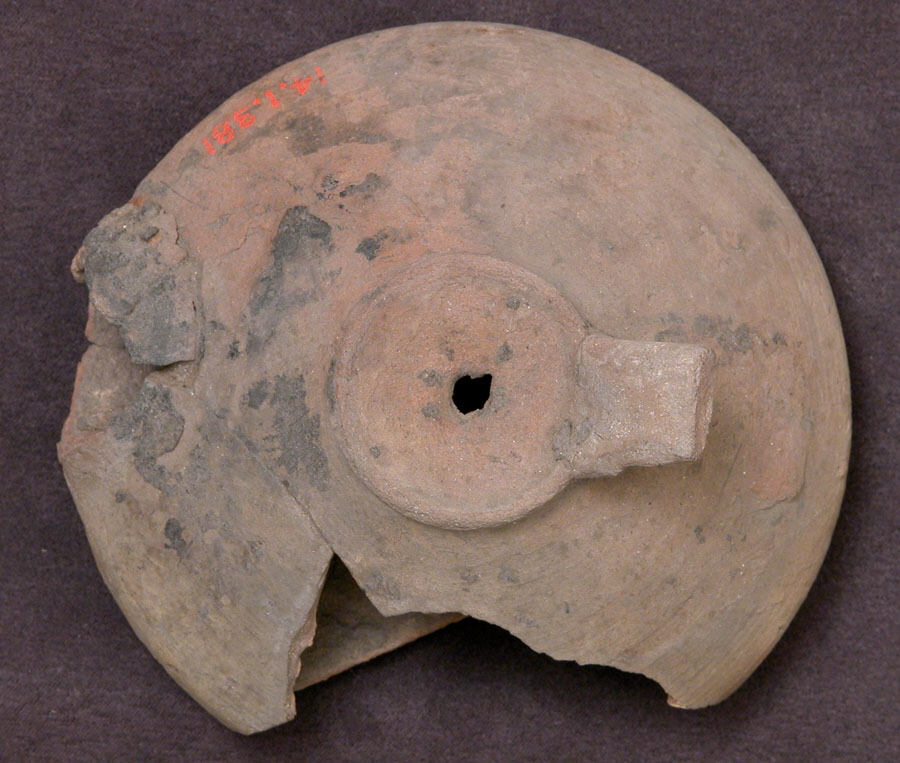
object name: lamp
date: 600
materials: earthenware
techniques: molding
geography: egypt